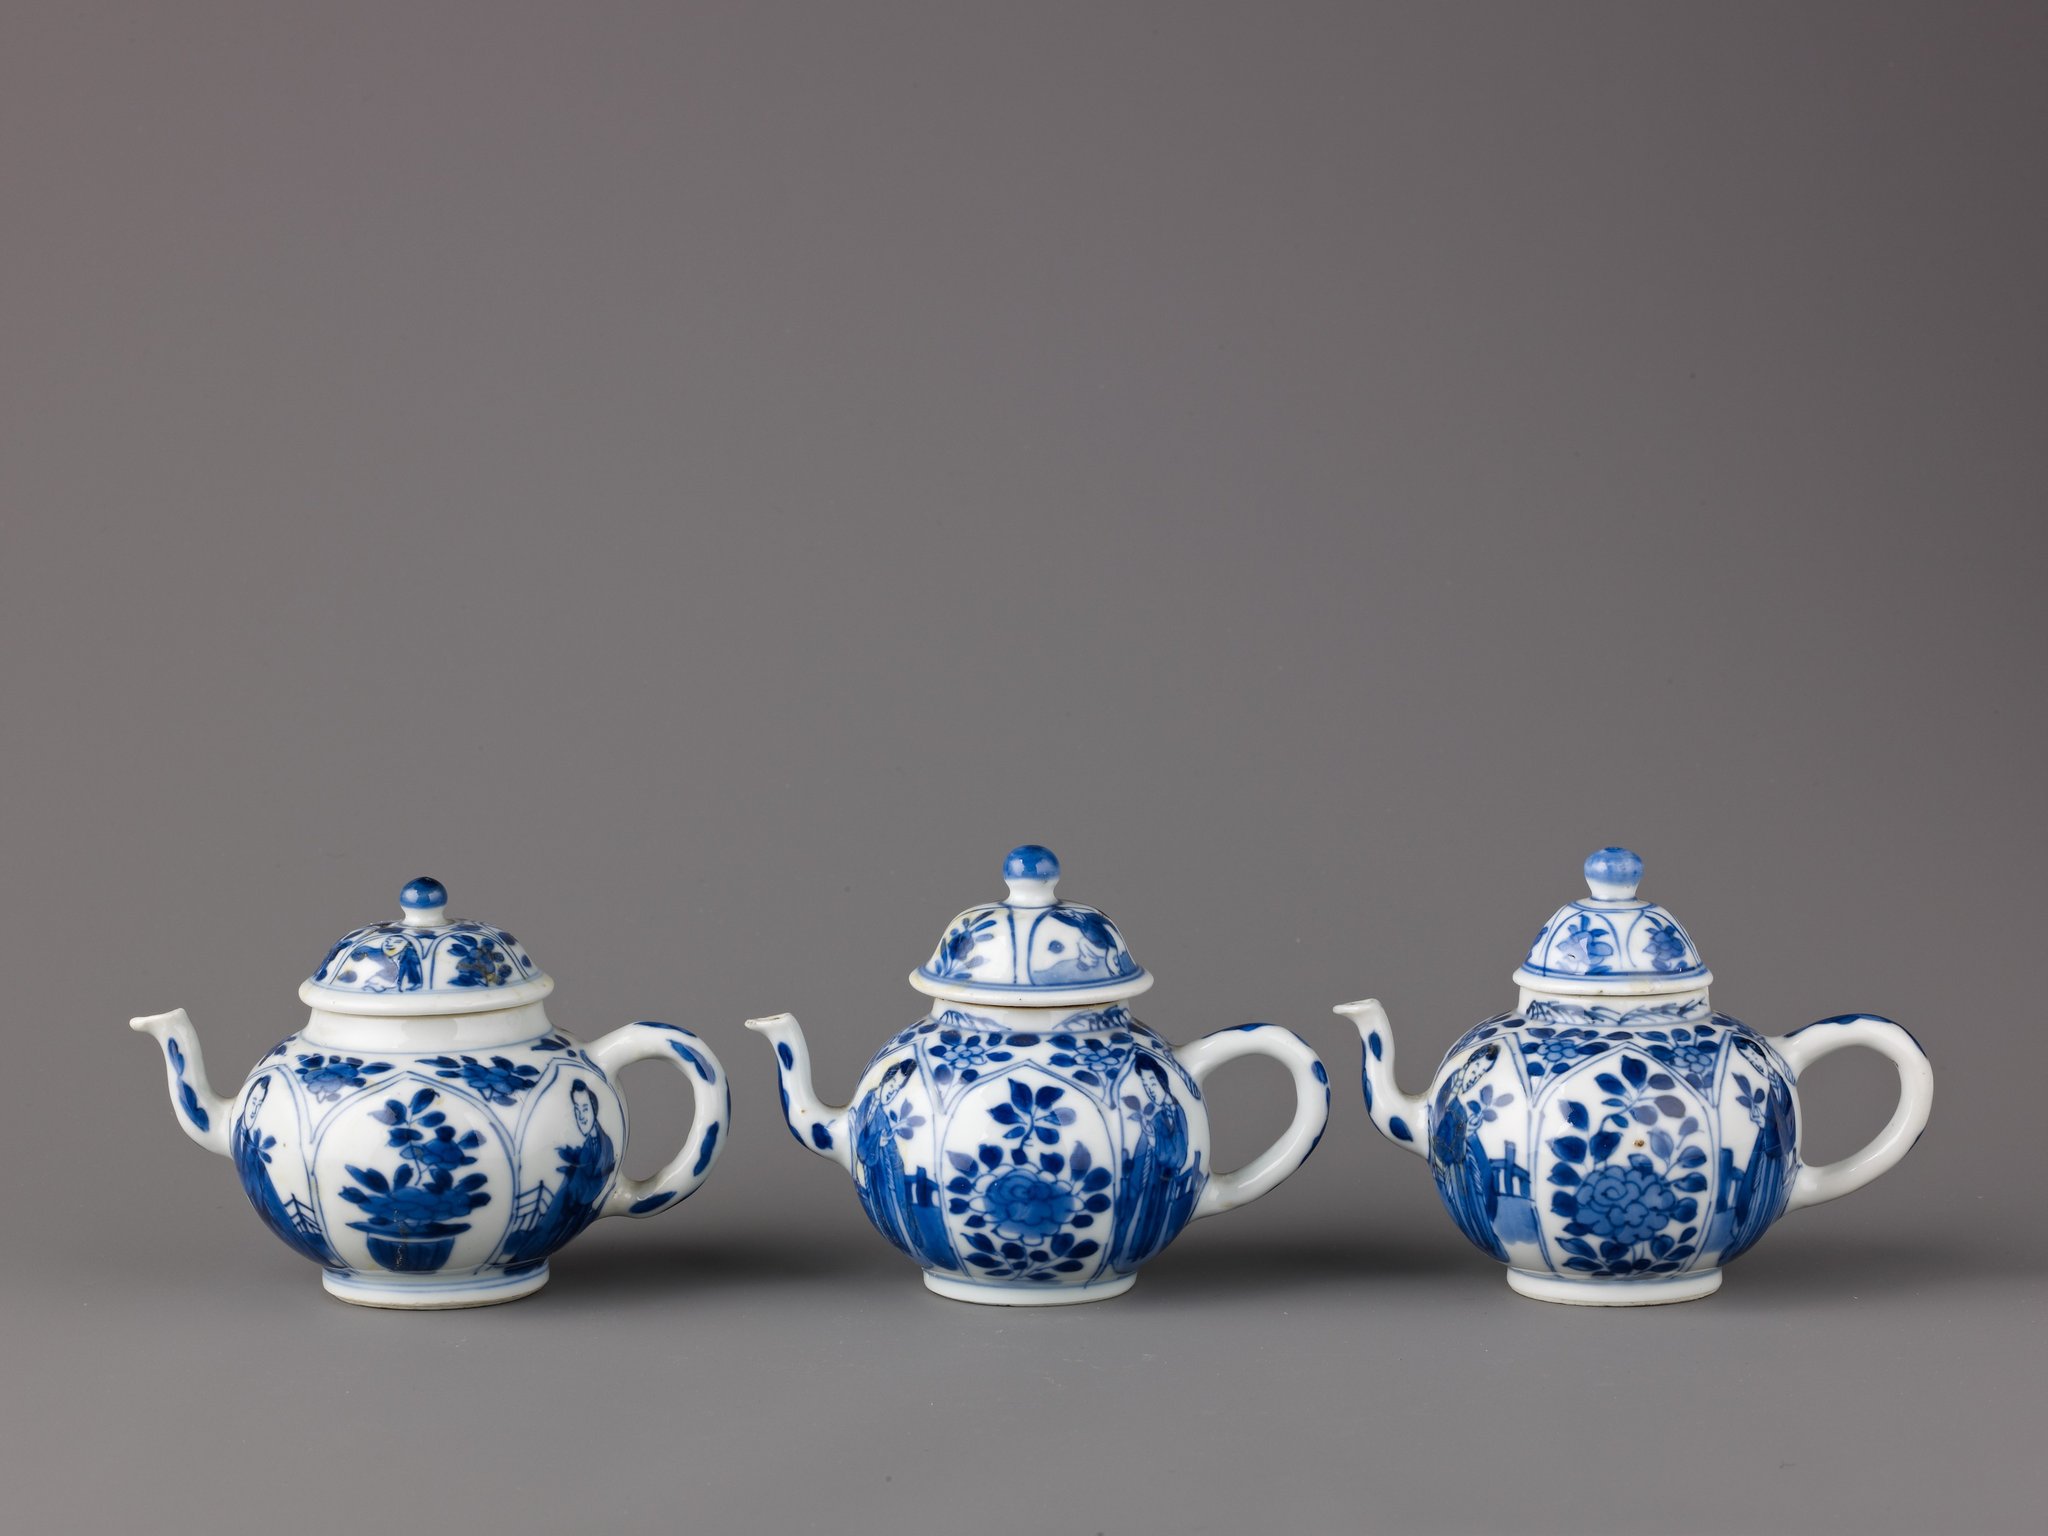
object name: covered winepot or teapot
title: Small covered wine pot or teapot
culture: chinese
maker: chinese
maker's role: artist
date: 1662-1722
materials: porcelain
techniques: painting, underglaze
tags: flowers